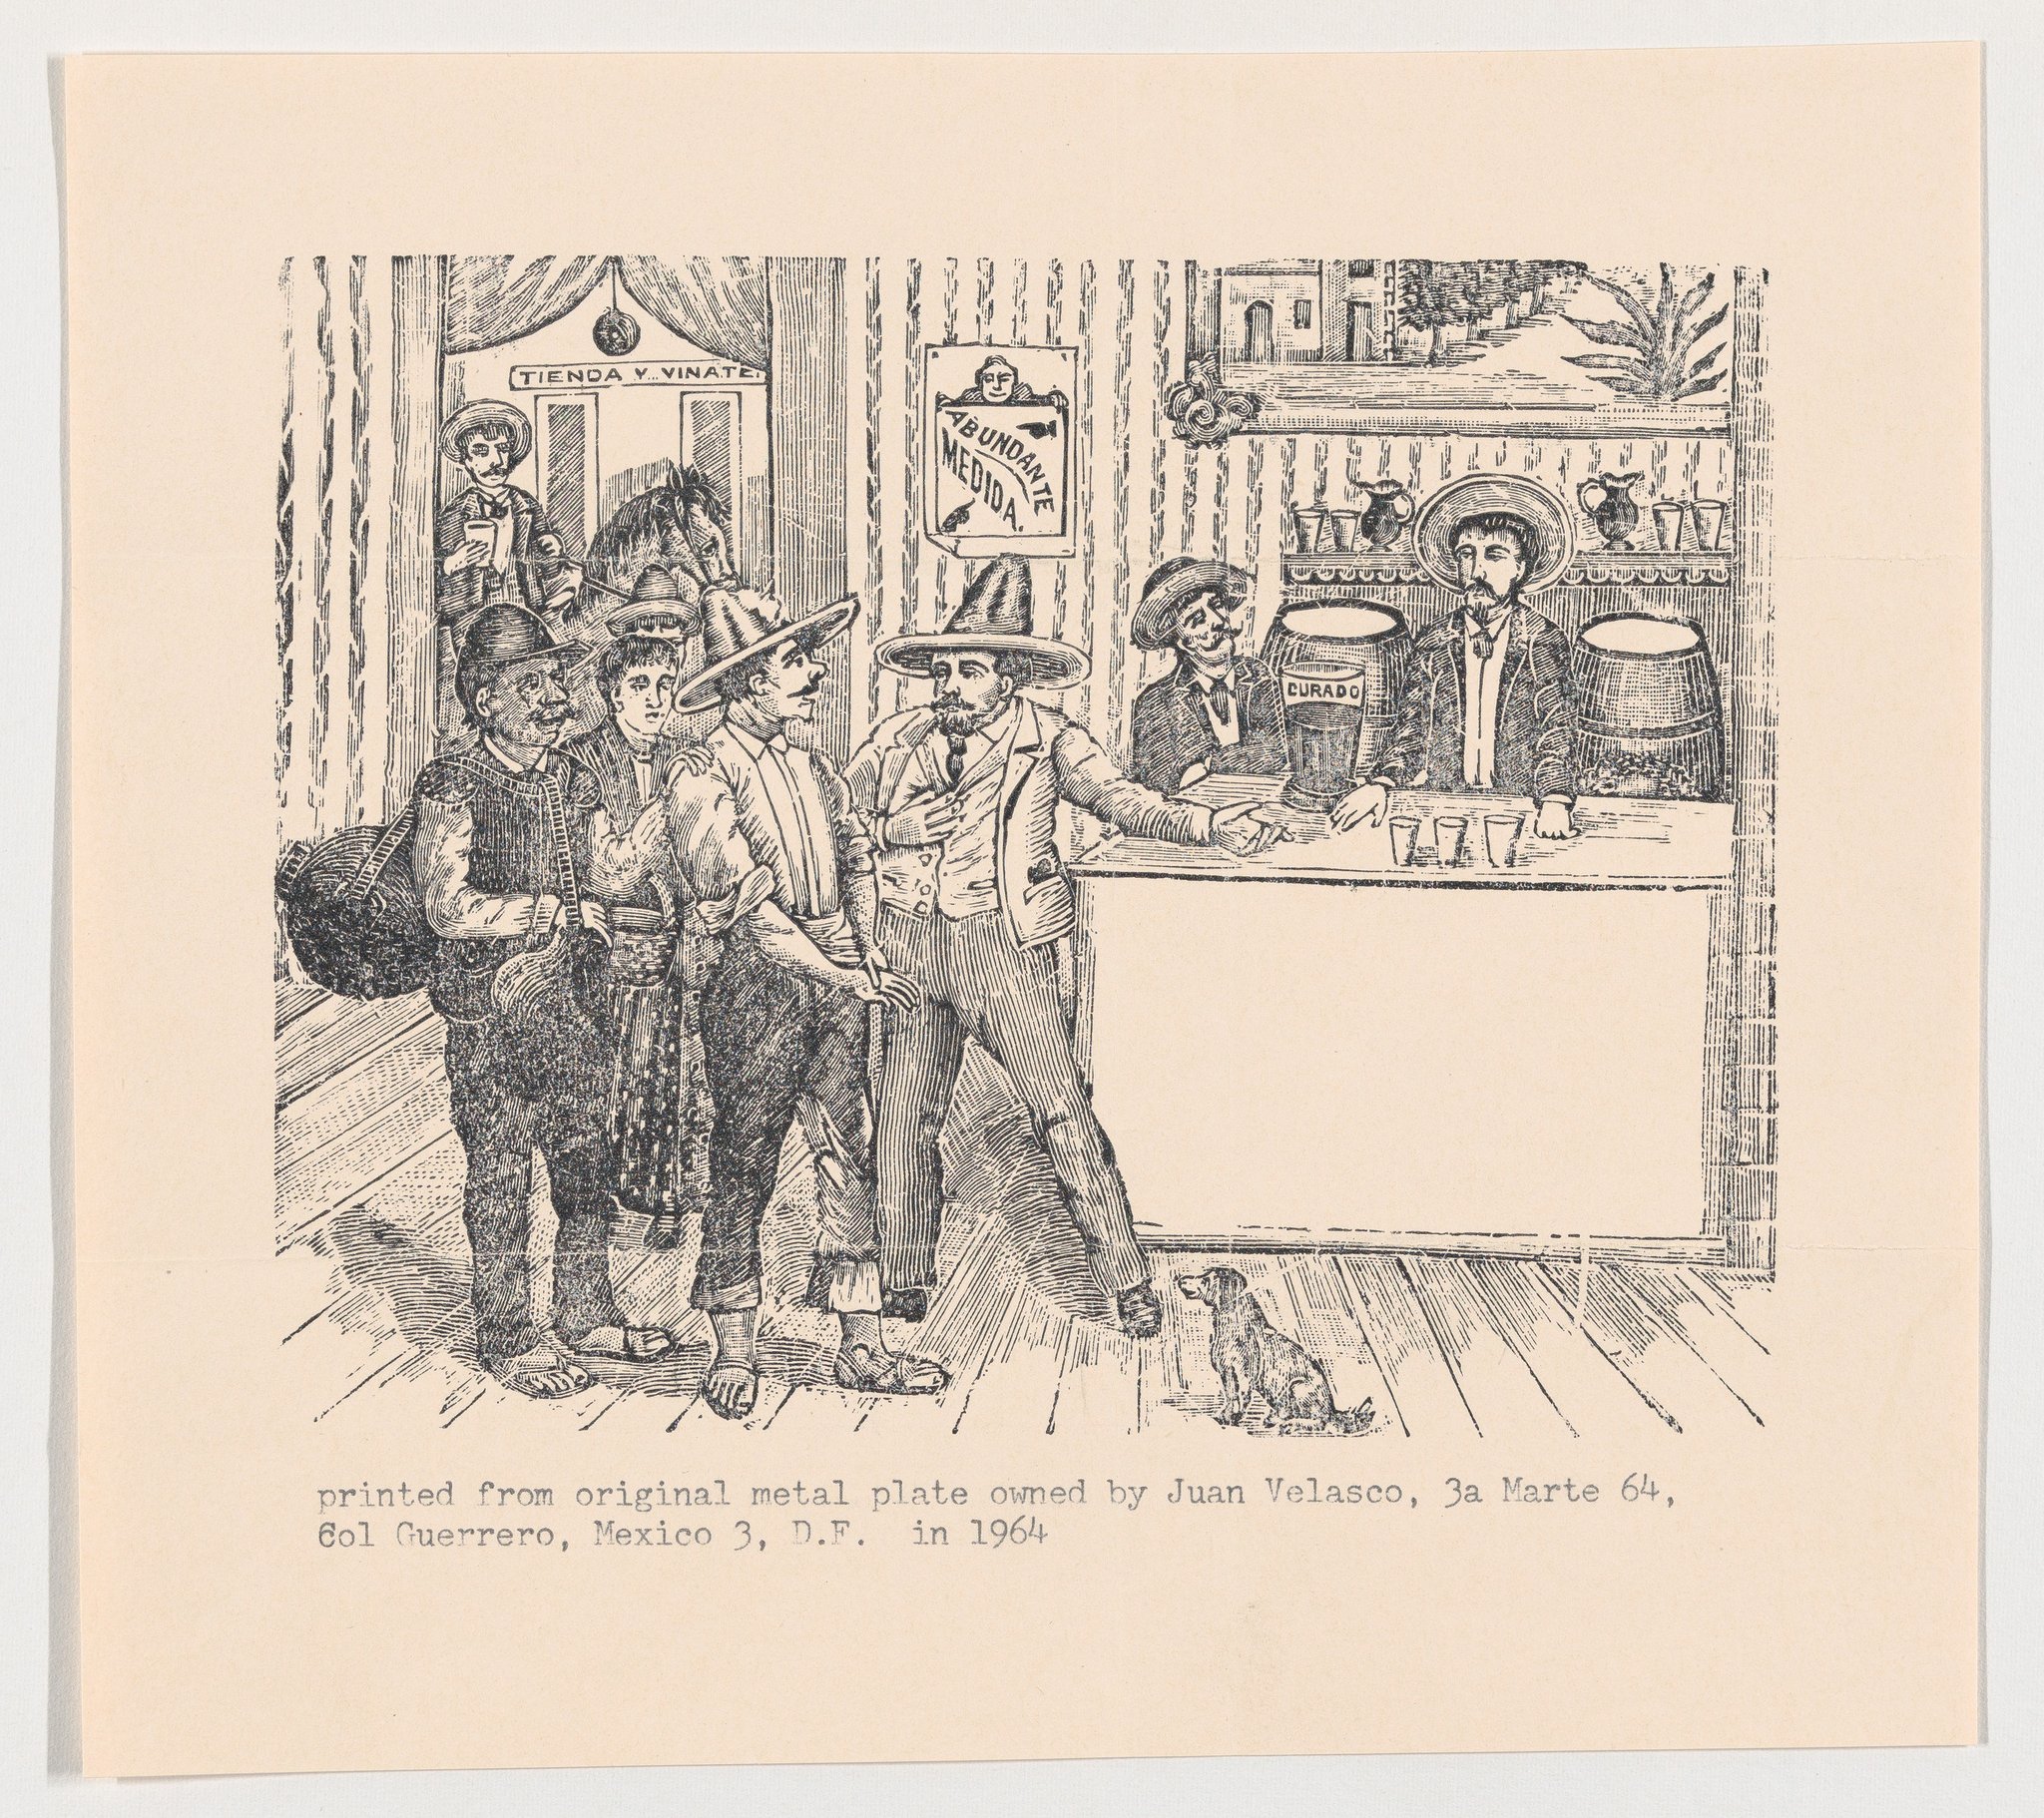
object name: print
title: Men in a tavern standing around a bar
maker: josé guadalupe posada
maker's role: artist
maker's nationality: mexican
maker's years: 1852-1913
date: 1890-1910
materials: metal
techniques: engraving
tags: taverns,men,dogs